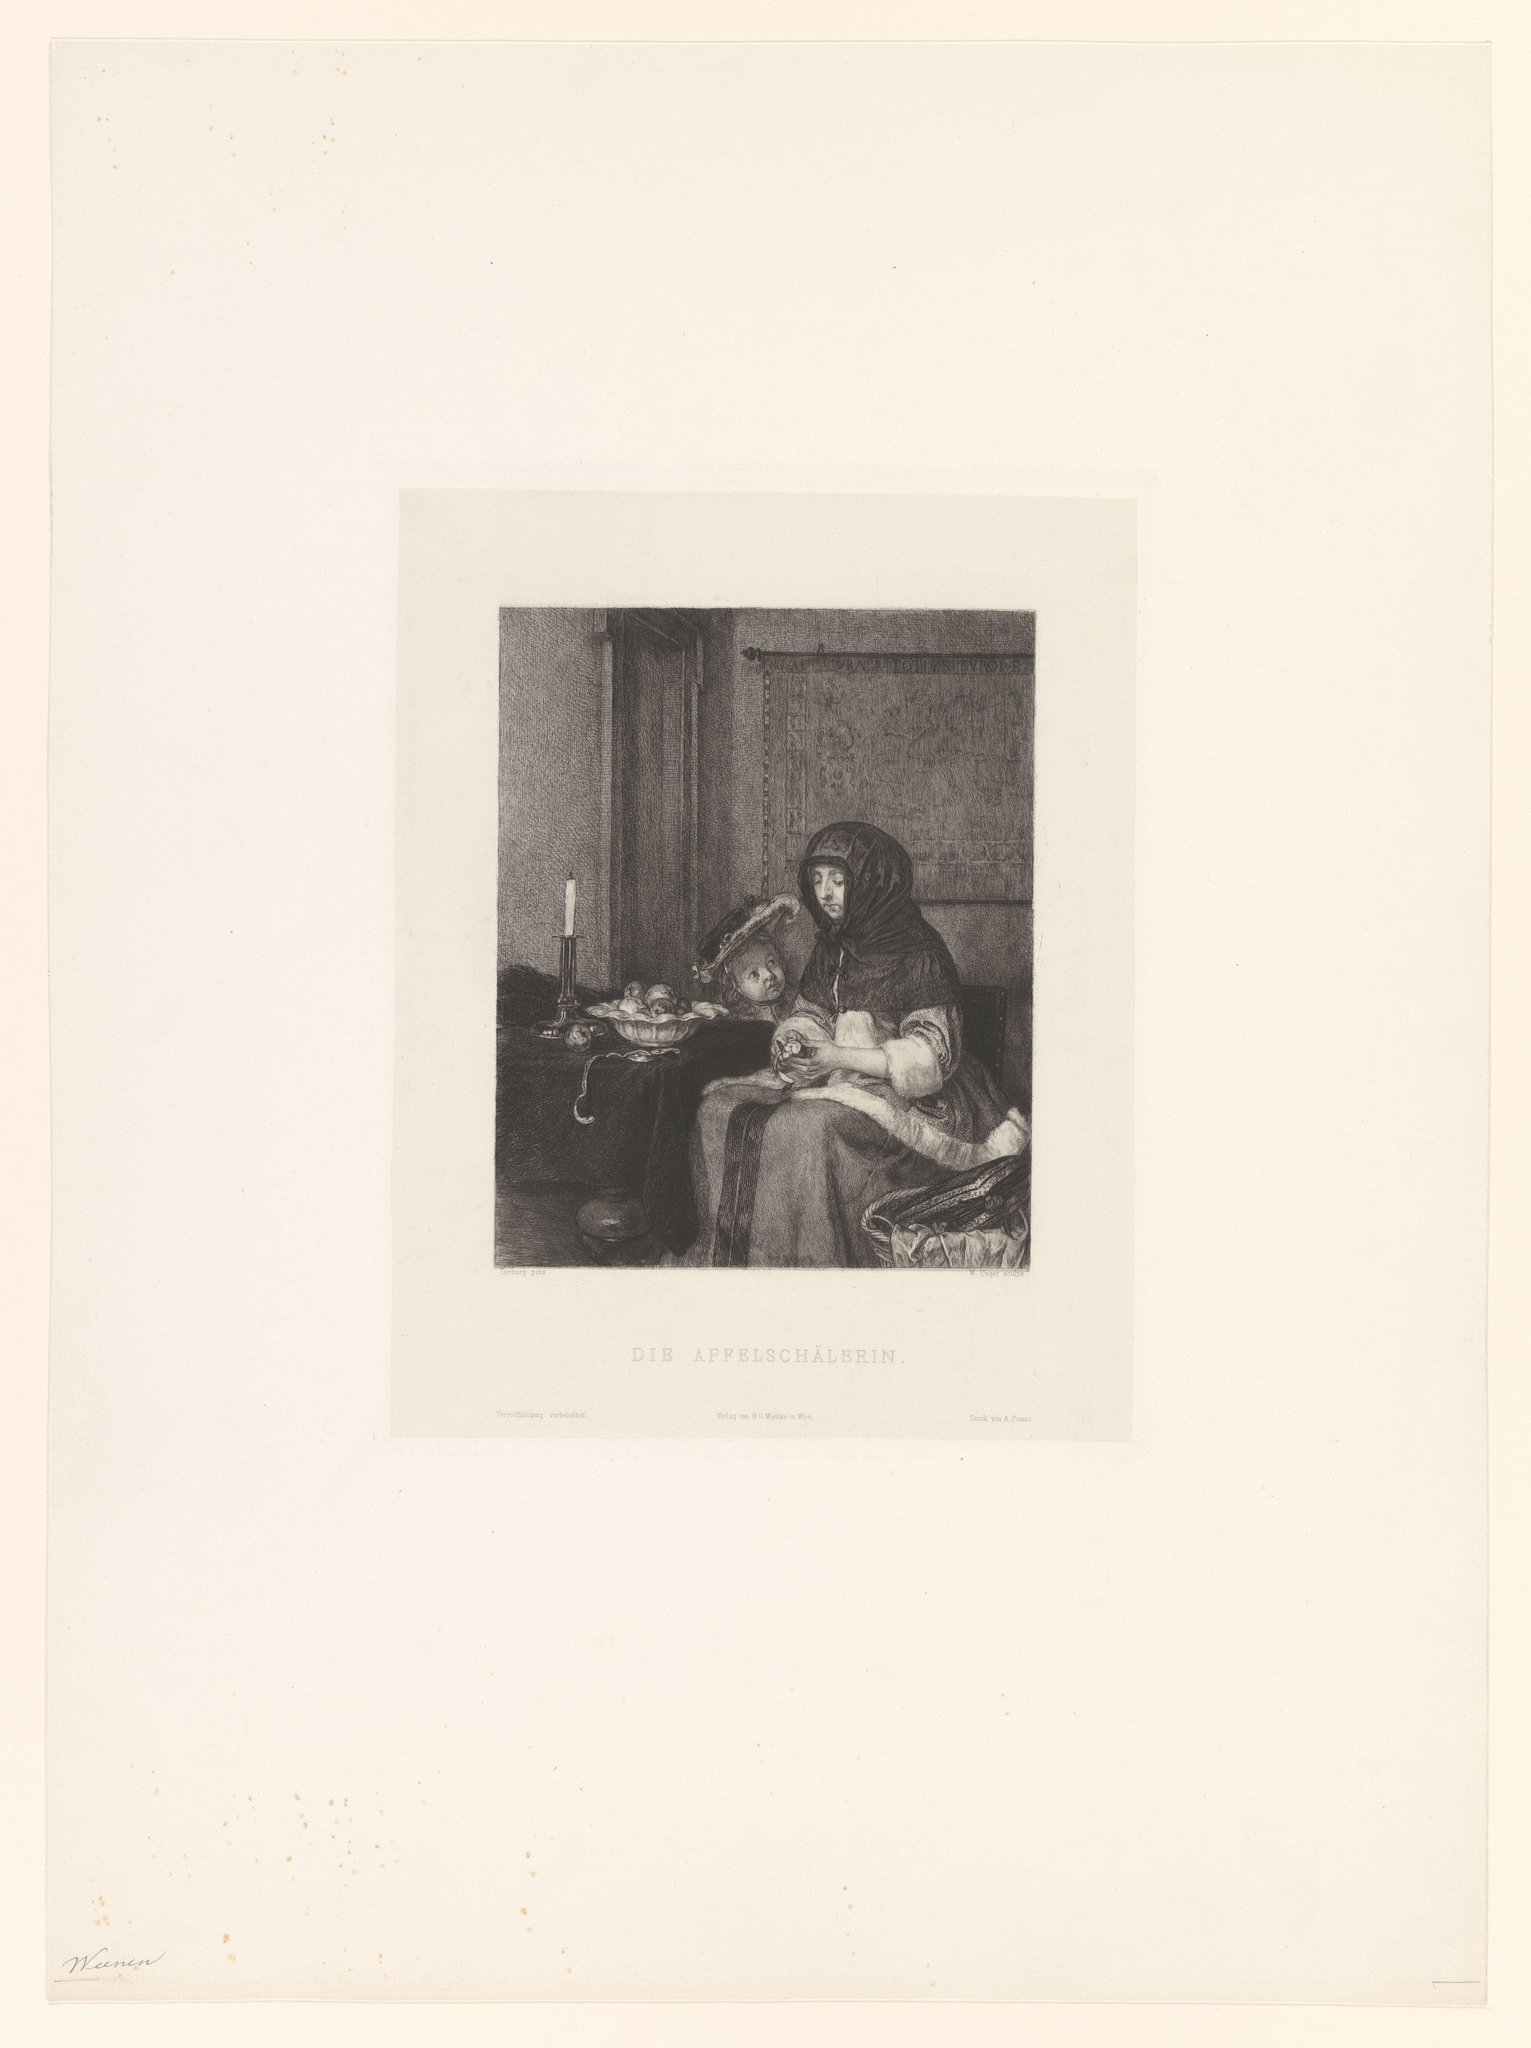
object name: print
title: Die Apfelschälerin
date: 1861-1889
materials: paper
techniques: etching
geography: vienna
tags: fruits: apple, cleaning fruit, e.g. peeling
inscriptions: collector's mark: Lugt 2228